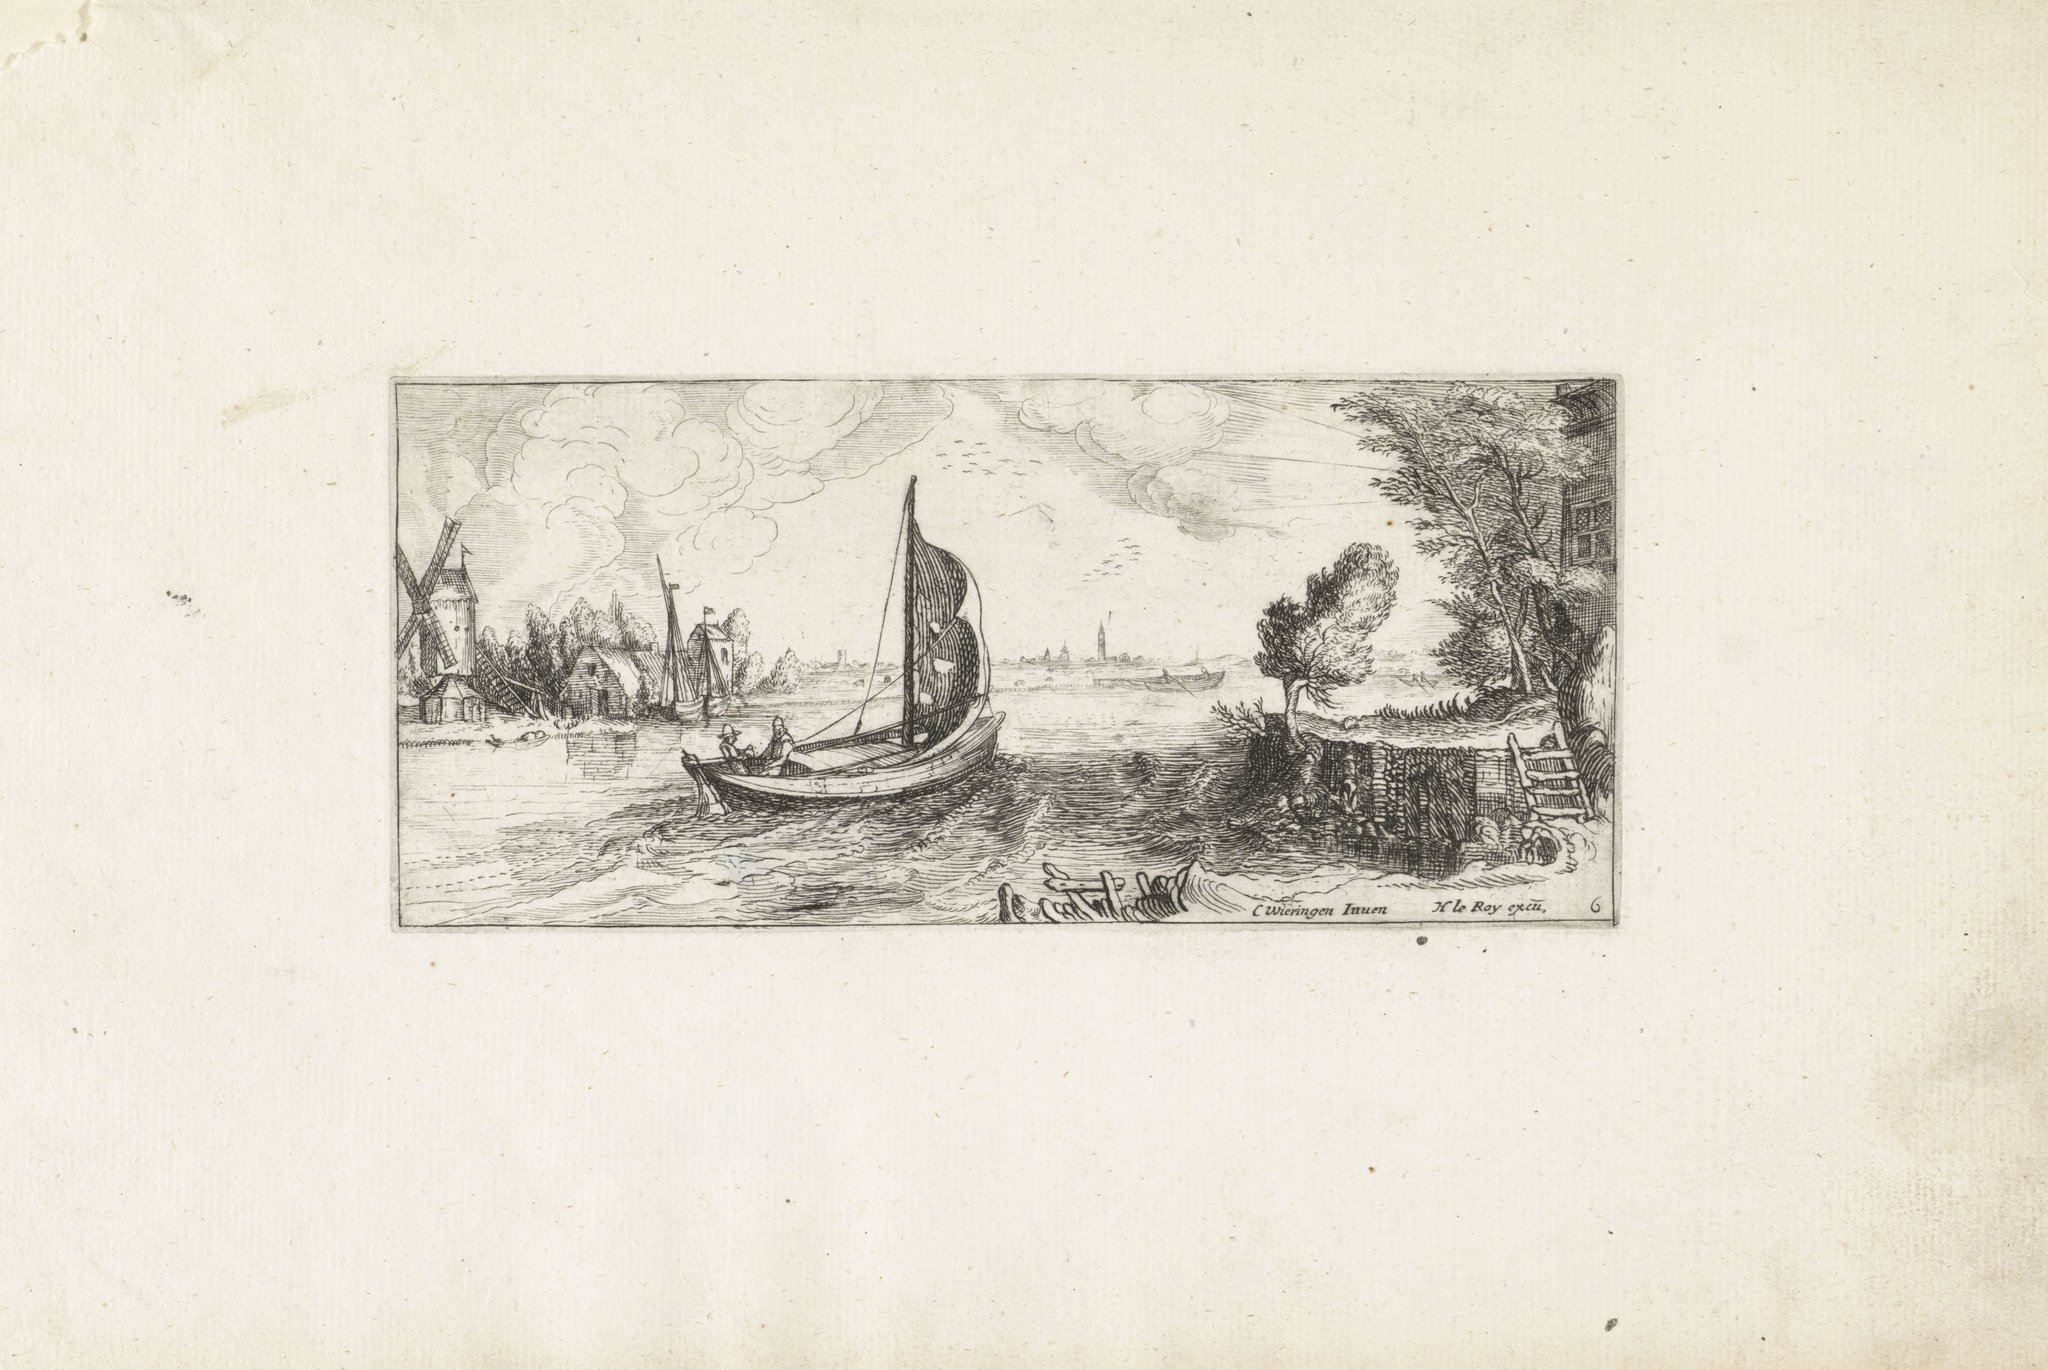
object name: print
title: Landschappen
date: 1614-1618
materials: paper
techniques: etching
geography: haarlem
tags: river, ships (in general), windmill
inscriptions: collector's mark: Lugt 2760, collector's mark: Lugt 2228